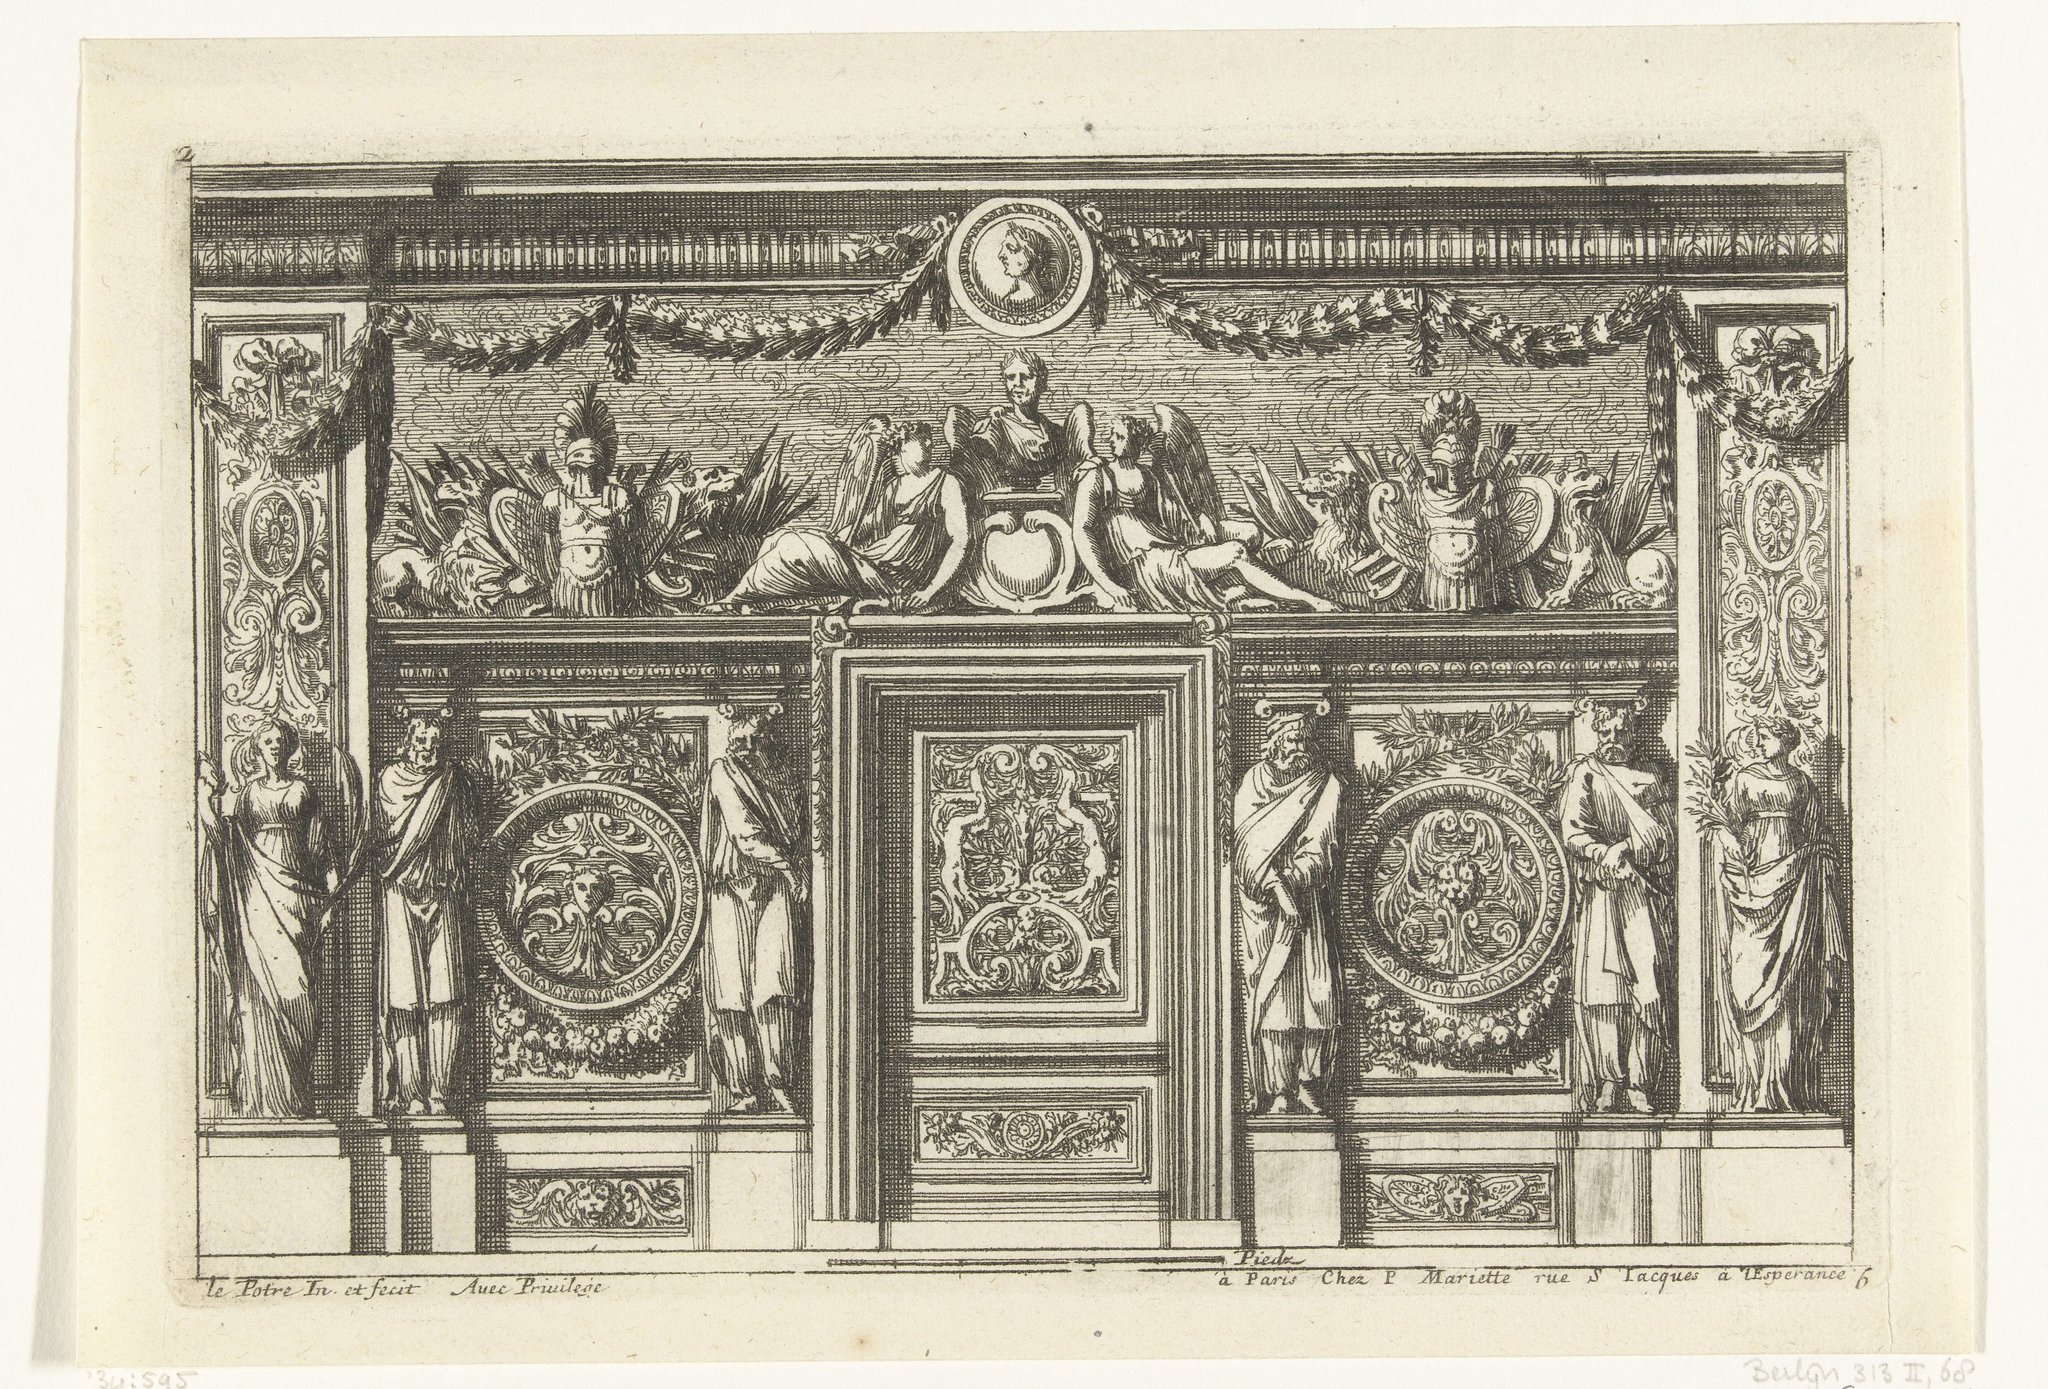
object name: ornament print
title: Koorhekken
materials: paper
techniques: etching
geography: france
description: Het koorhek is bekroond met een wapentrofee en een keizersbuste. Uit derde editie.